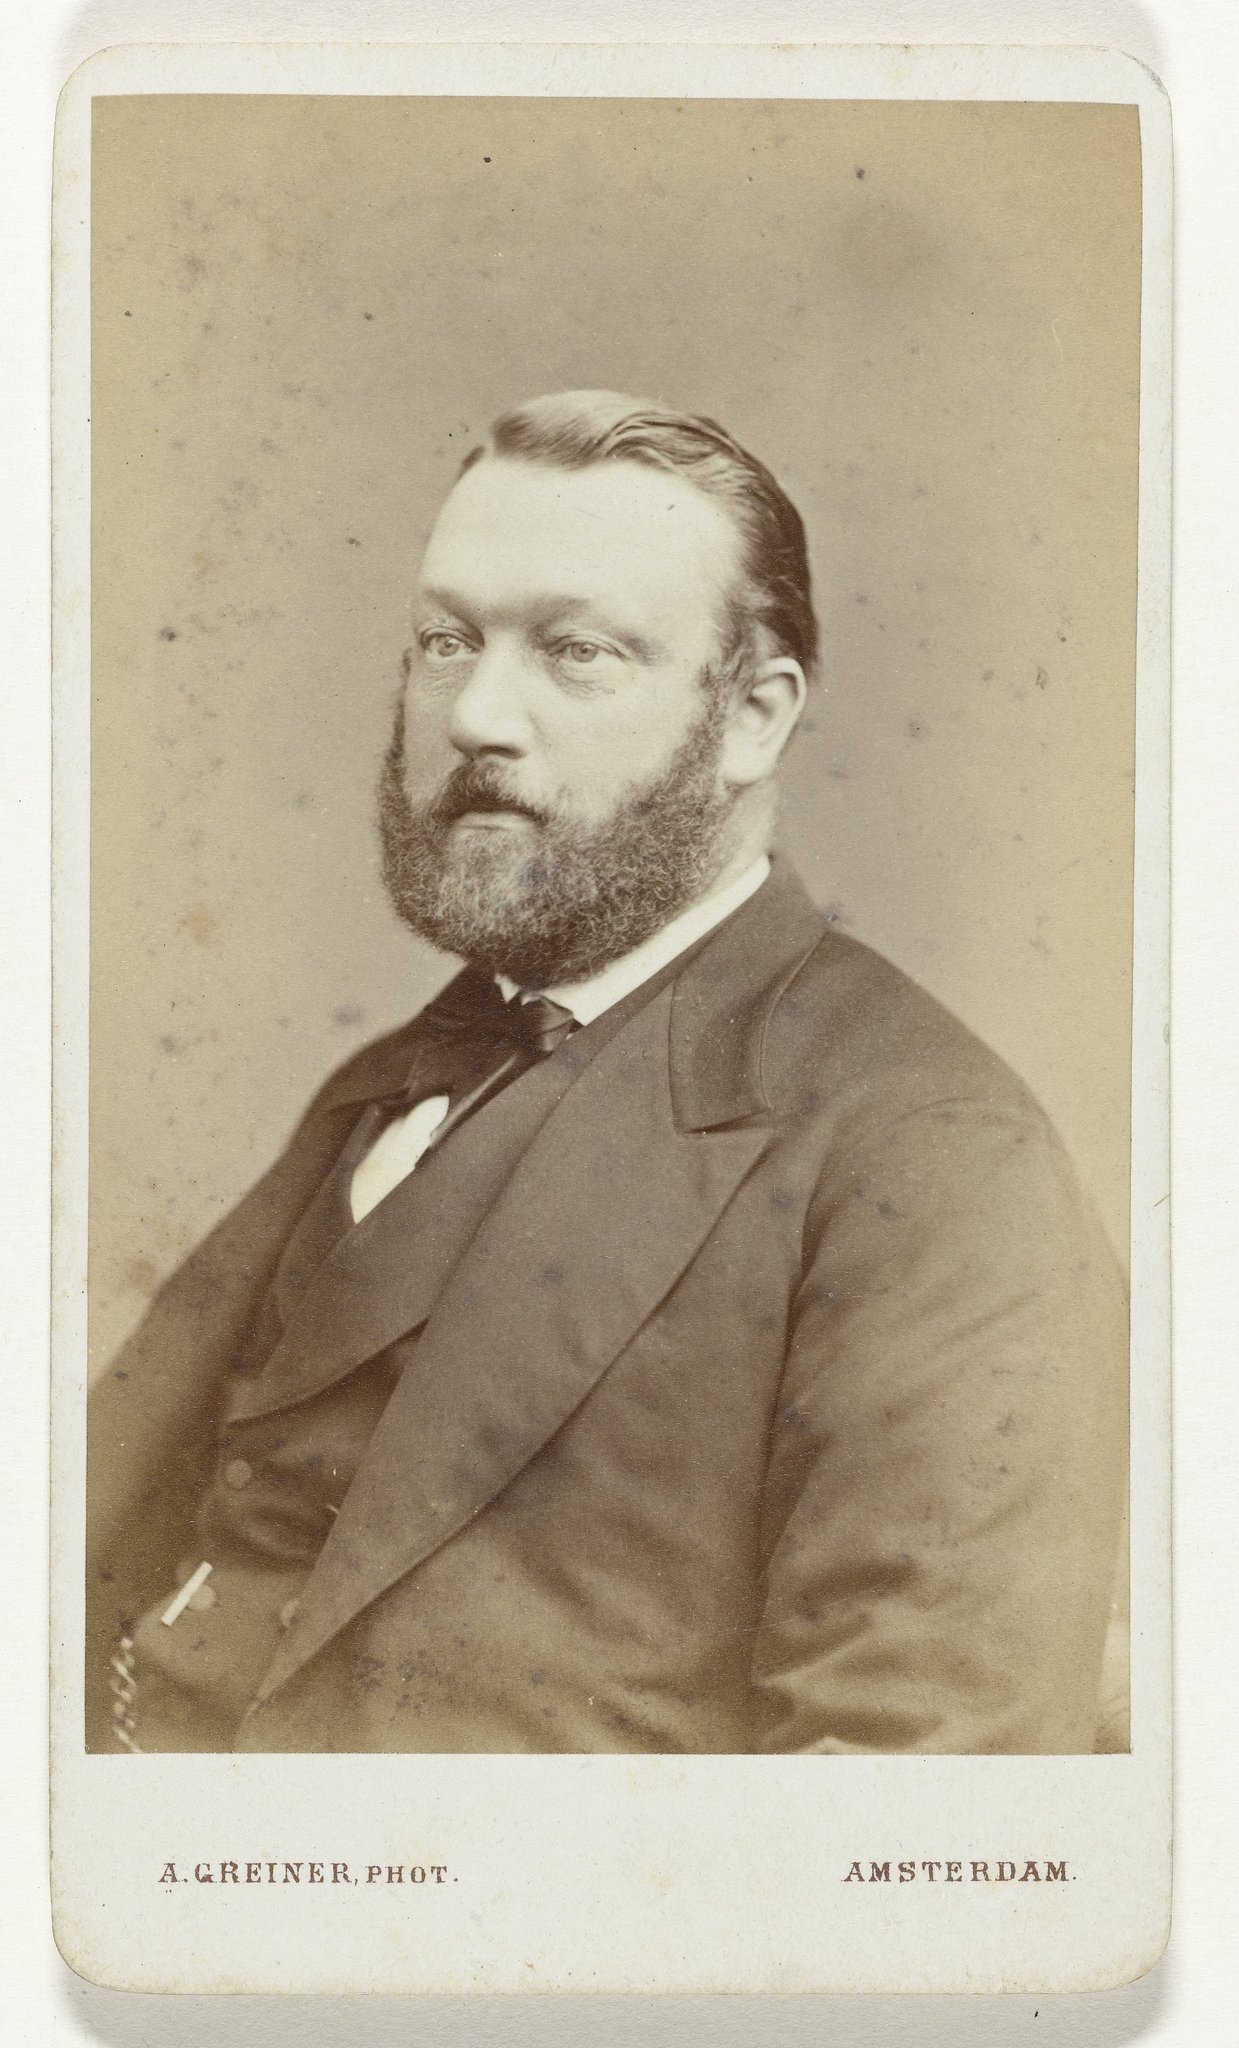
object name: photograph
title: Portret van een man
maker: albert greiner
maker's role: fotograaf, fotostudio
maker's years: 1833-1890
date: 1864-1875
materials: cardboard, paper, photographic support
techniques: albumen print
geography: amsterdam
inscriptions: signature and address: ‘AG/A. Greiner/Photograf/Nieuwendijk.L.87/Amsterdam’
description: Buste van een man met baard, naar links.